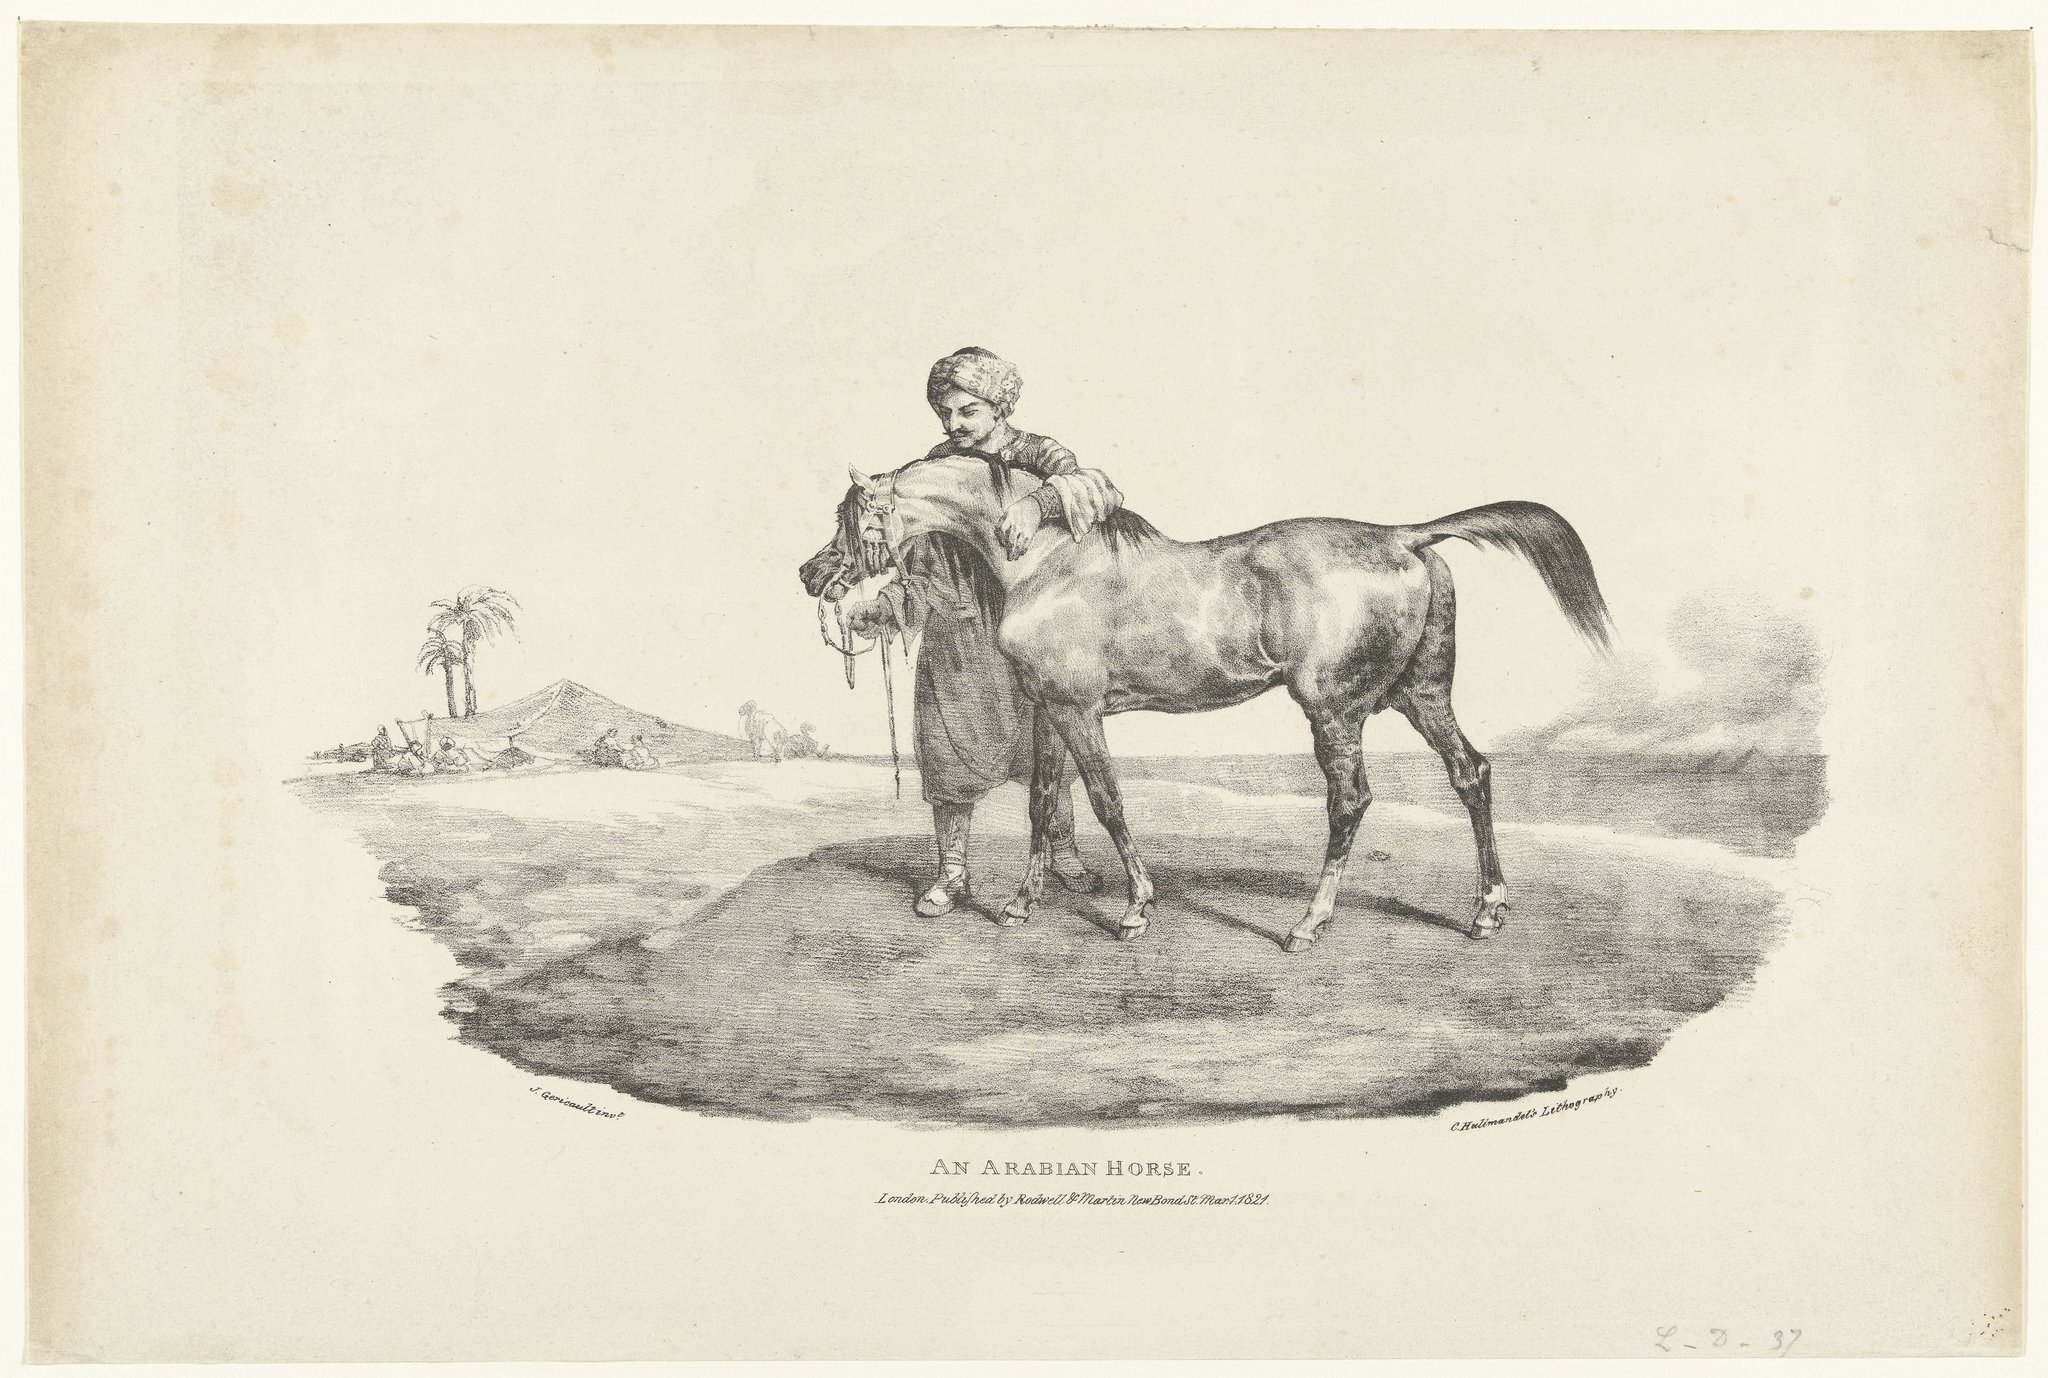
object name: print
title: Arabisch volbloedpaard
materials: paper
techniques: lithograph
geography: london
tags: horse (with name of race or kind)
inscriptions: collector's mark: Lugt 2228, collector's mark: Lugt 2760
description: Een Arabisch volbloedpaard wordt vastgehouden door een man met tulband in de woestijn. In de verte een tent met enkele personen.